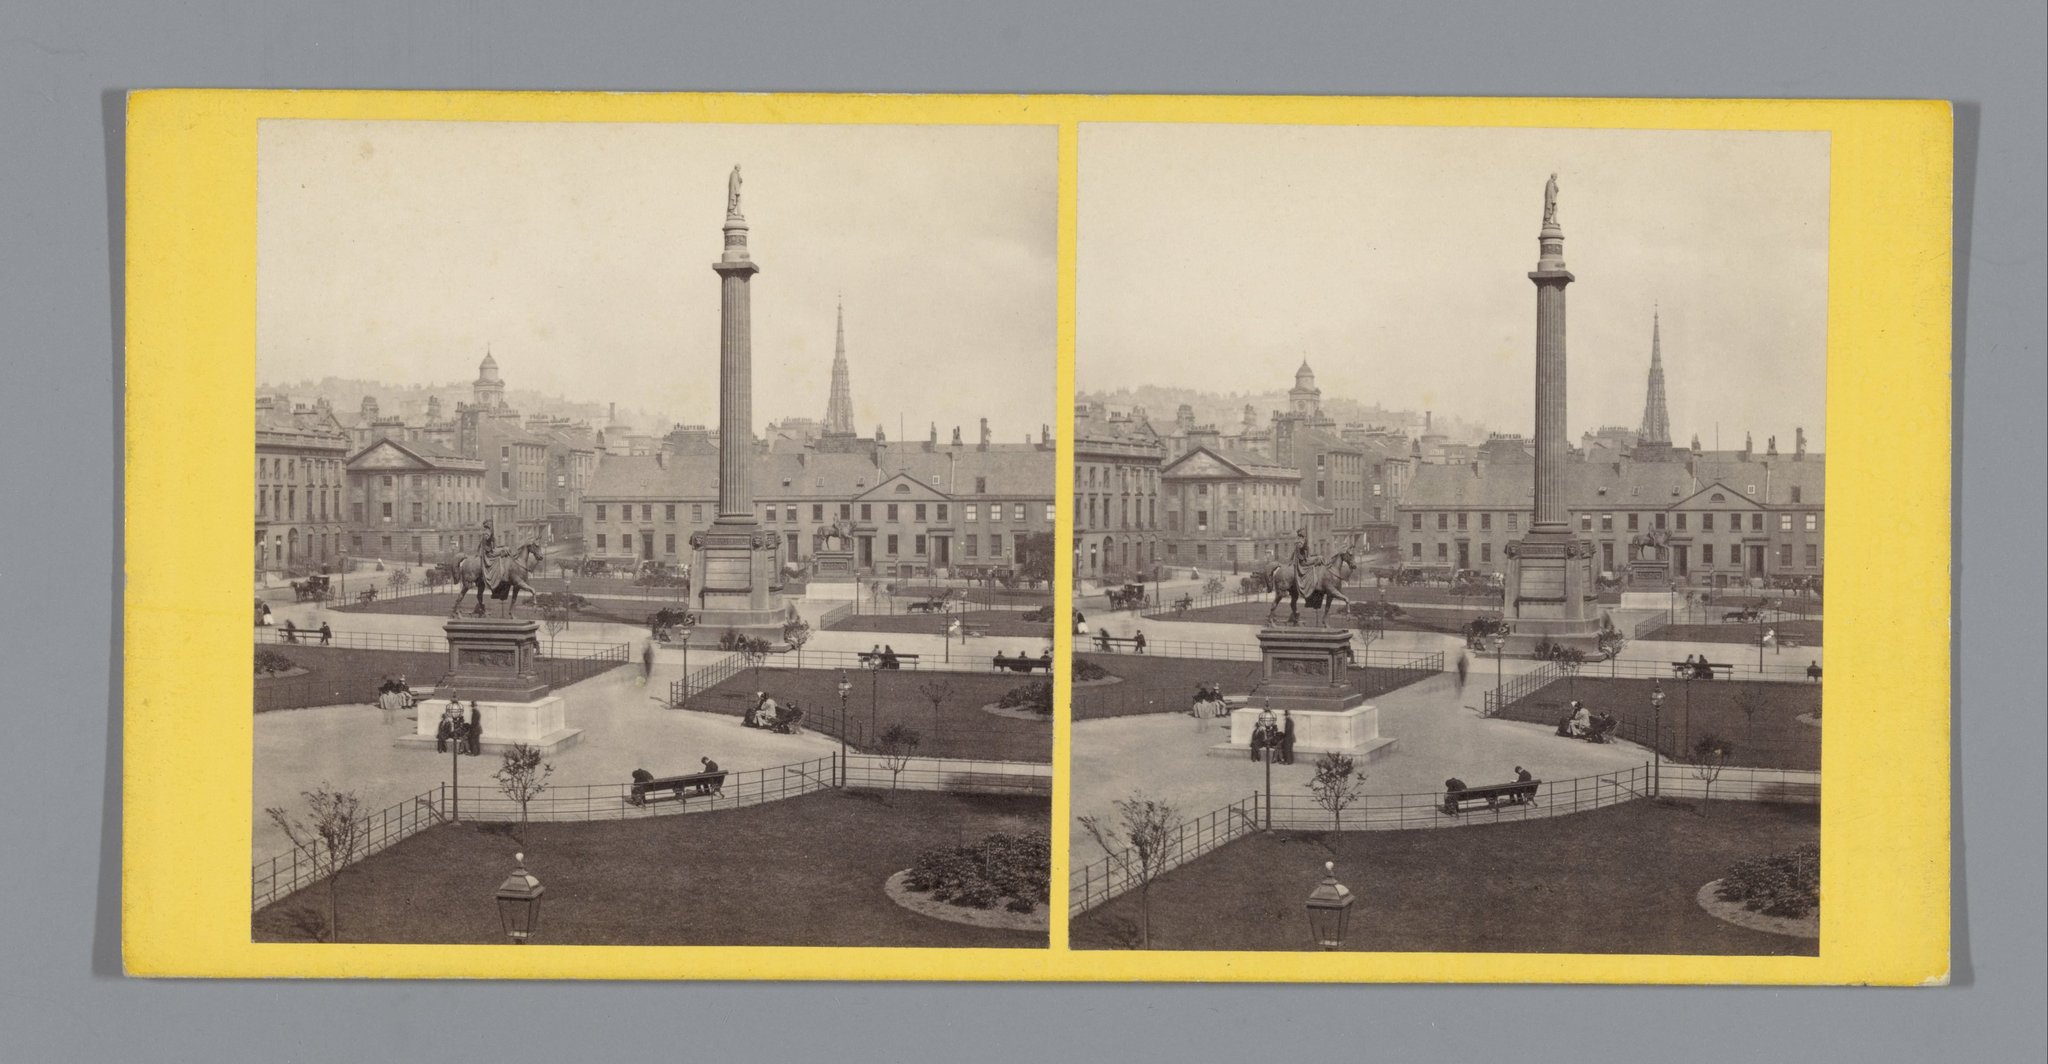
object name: stereograph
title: George Square, Glasgow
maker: george washington wilson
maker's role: publisher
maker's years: 1823-1893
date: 1858-1872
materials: cardboard, photographic support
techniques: albumen print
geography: glasgow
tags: square, place, circus, etc., monument, statue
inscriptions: number: ‘No. 802.’